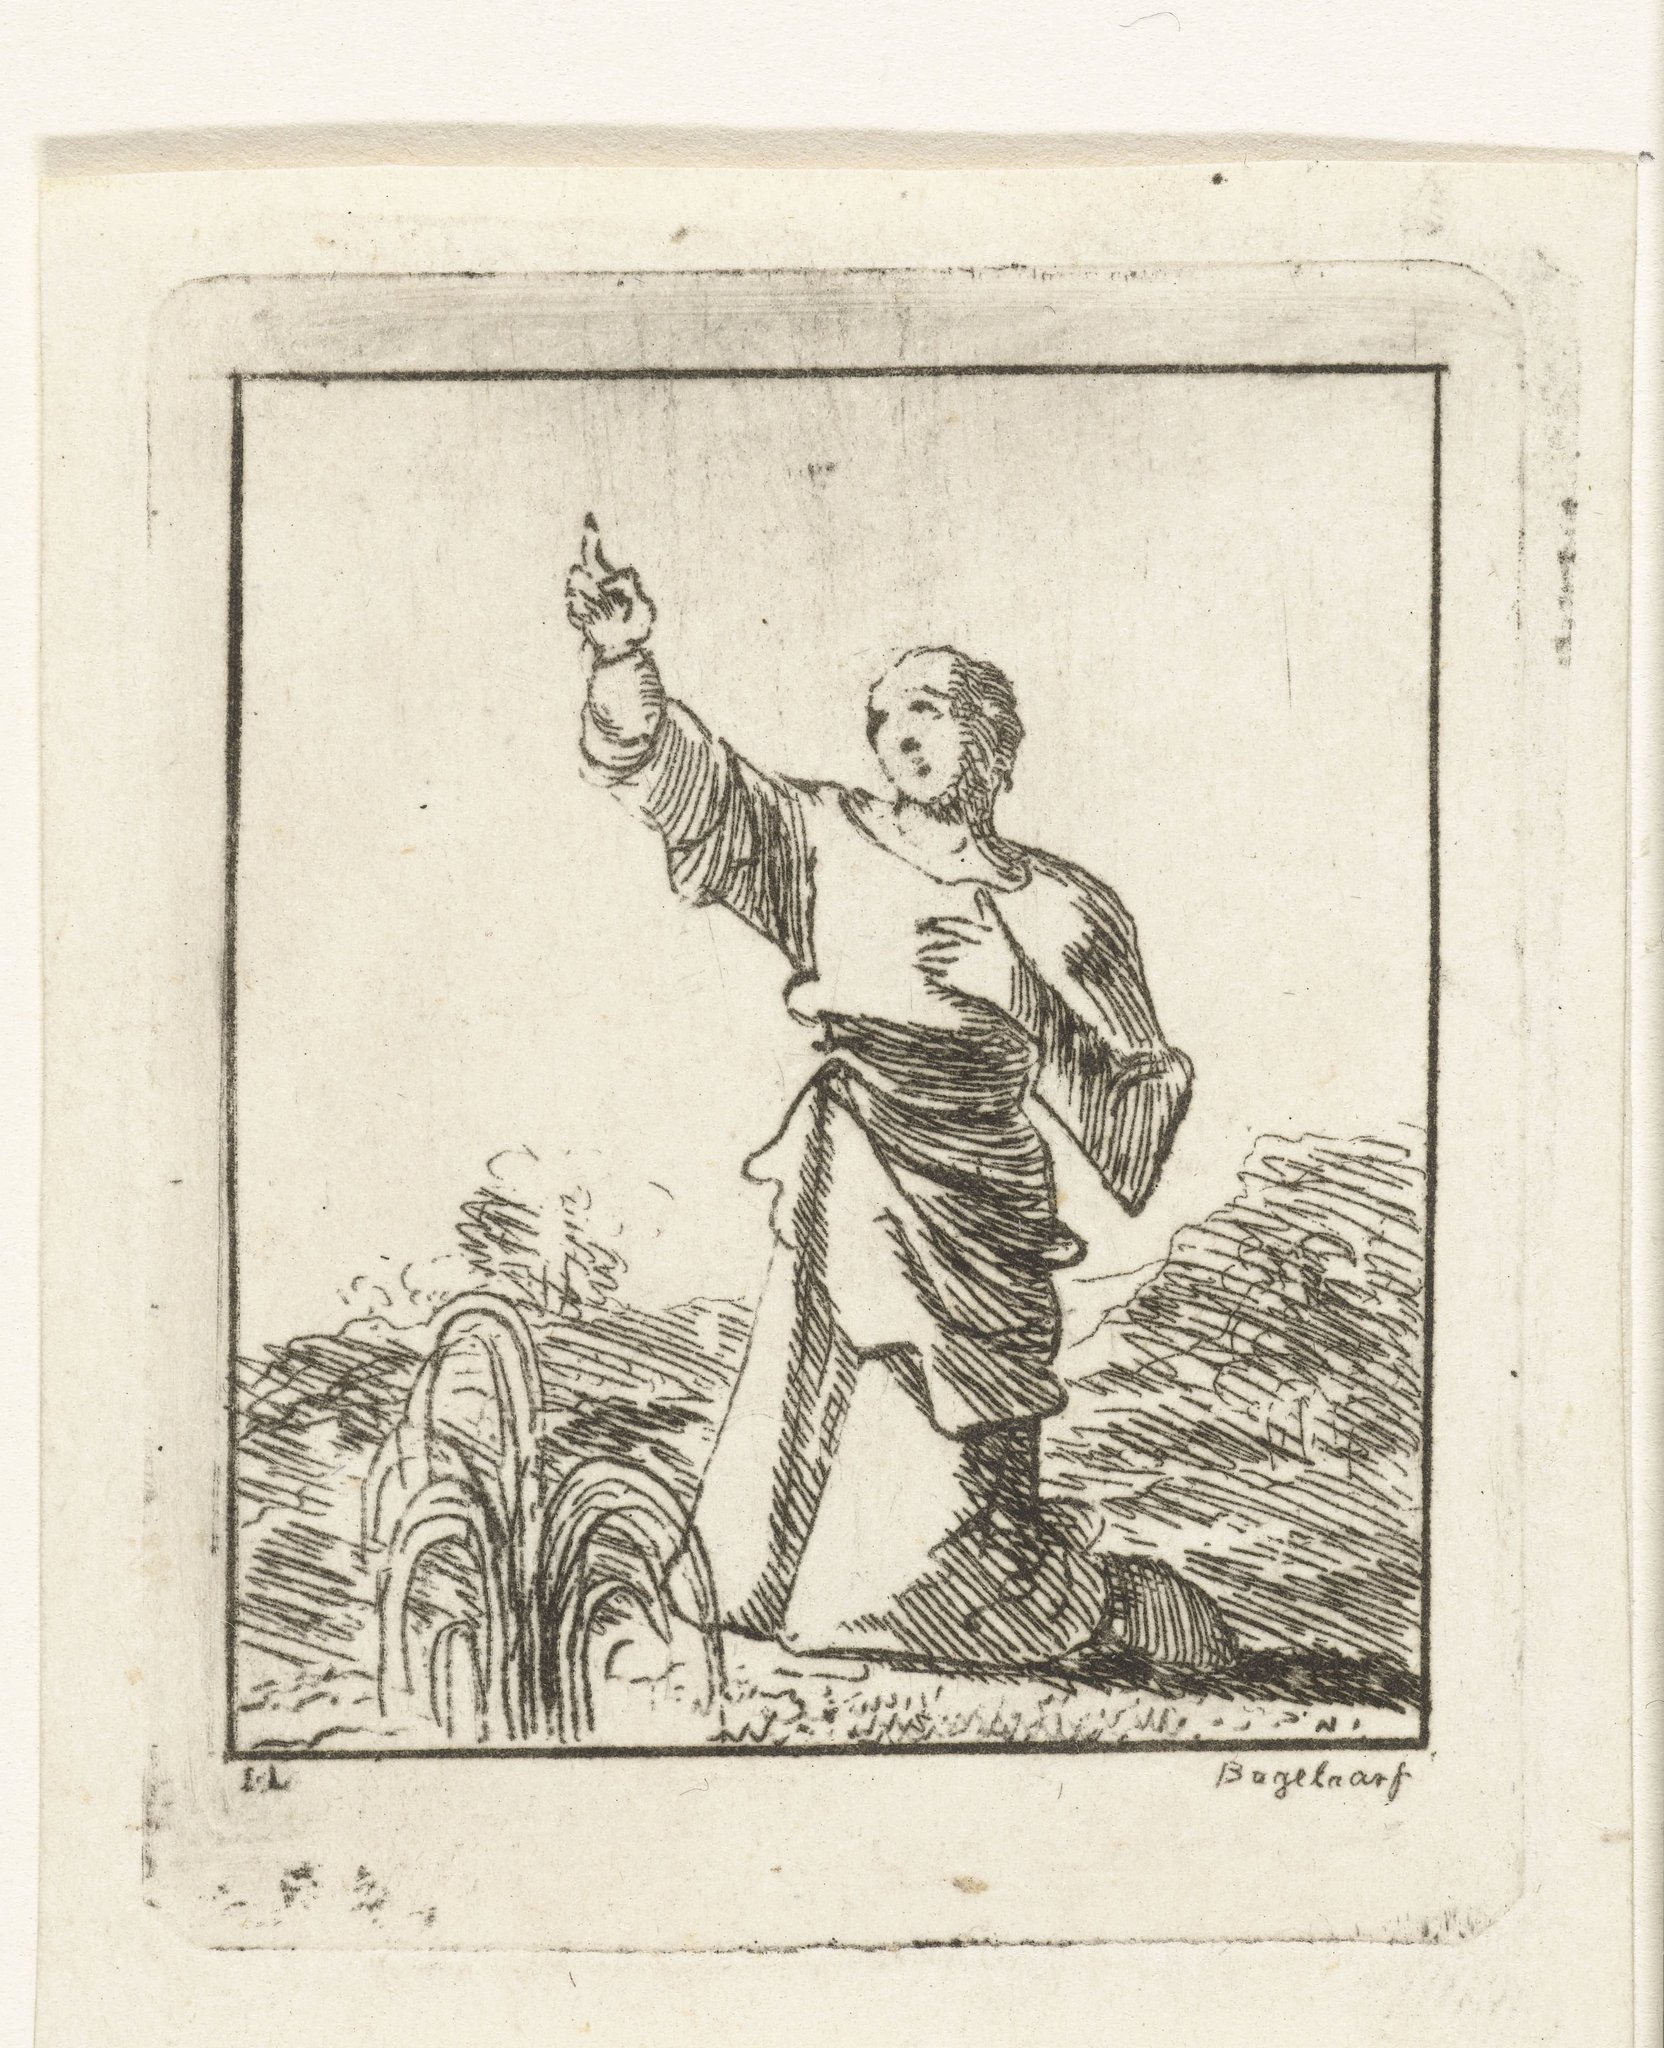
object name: print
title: De ziel wijst naar de sterrenhemel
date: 1798-1837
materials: paper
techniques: etching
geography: netherlands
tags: stars in the firmament, christ and the soul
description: Een knielende man, de personificatie van de ziel, wijst naar de sterrenhemel. Deze prent verbeeldt een detail van een tekening van Jan Luyken getiteld: Christus en de ziel beschouwen de sterrenhemel.